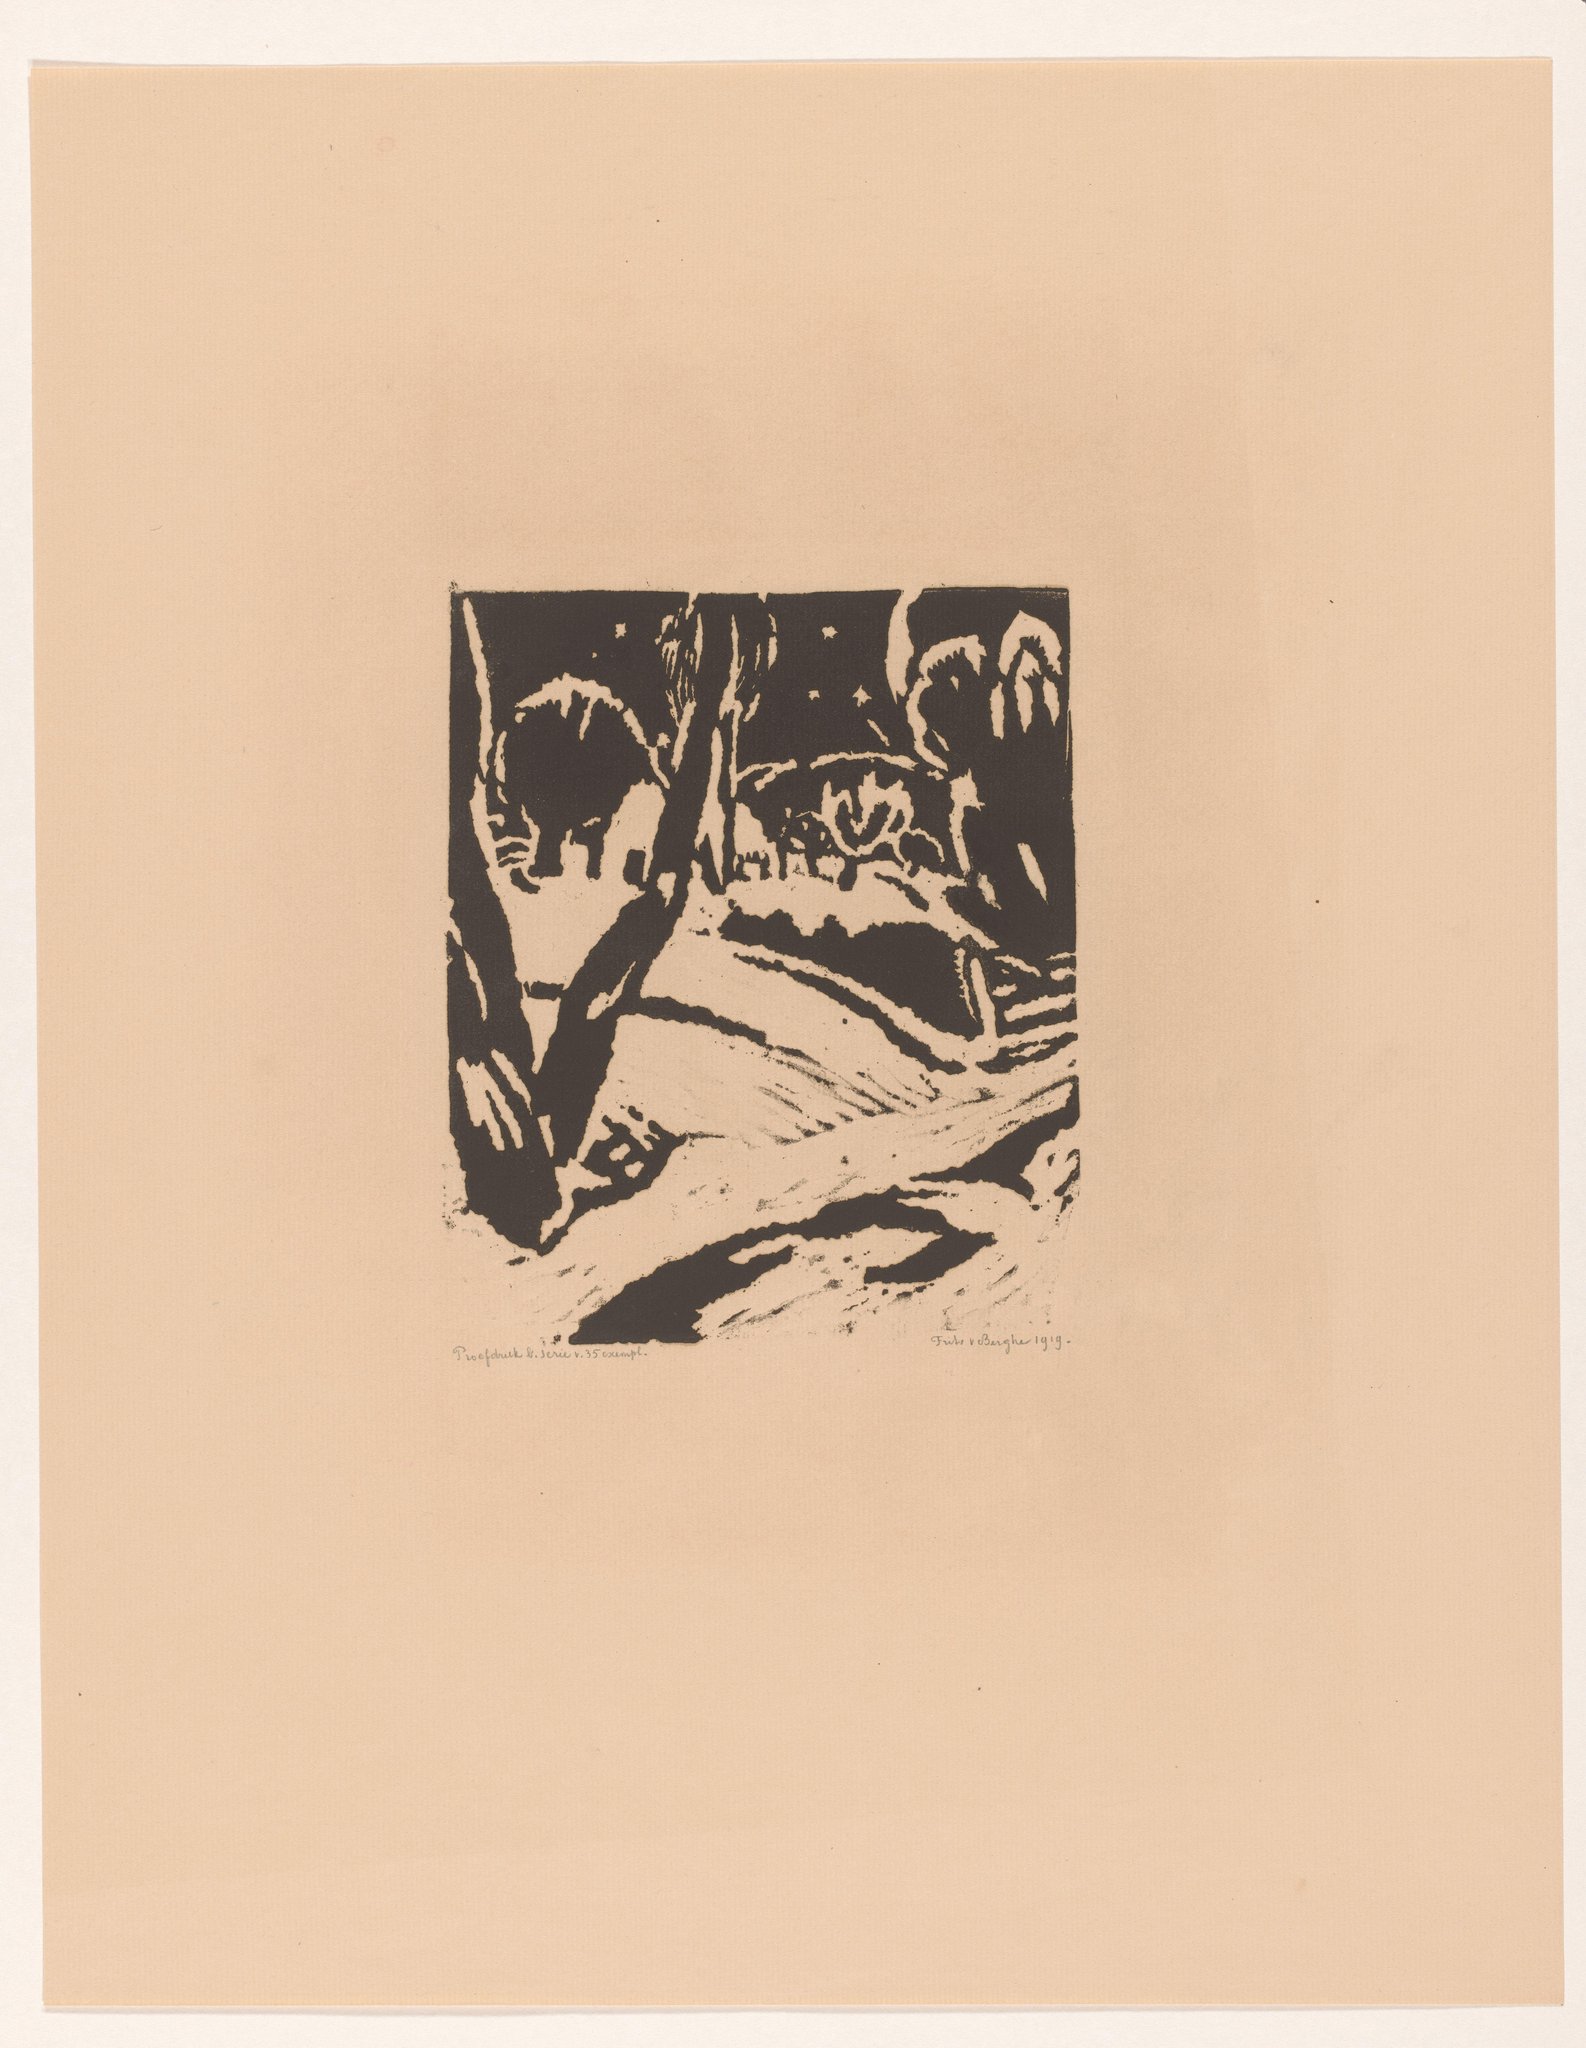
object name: print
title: Heuvellandschap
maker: frits van den berghe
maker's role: print maker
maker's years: 1883-1939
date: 1919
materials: paper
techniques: woodcut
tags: low hill country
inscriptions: annotation: ‘Proefdruk v. serie v. 35 exempl.’, collector's mark: Lugt 2228